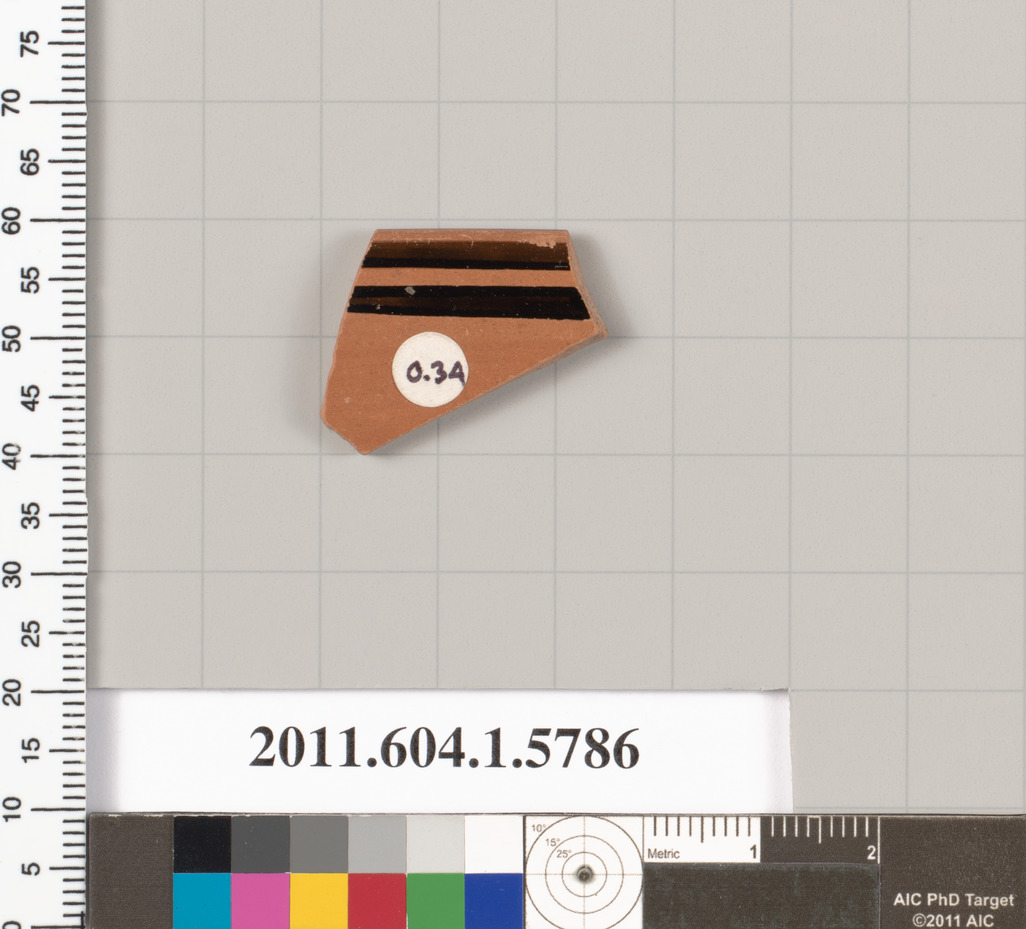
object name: kylix fragment, eye cup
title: Terracotta rim fragment of a kylix: eye-cup (drinking cup)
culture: greek, attic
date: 520-510 BCE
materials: terracotta